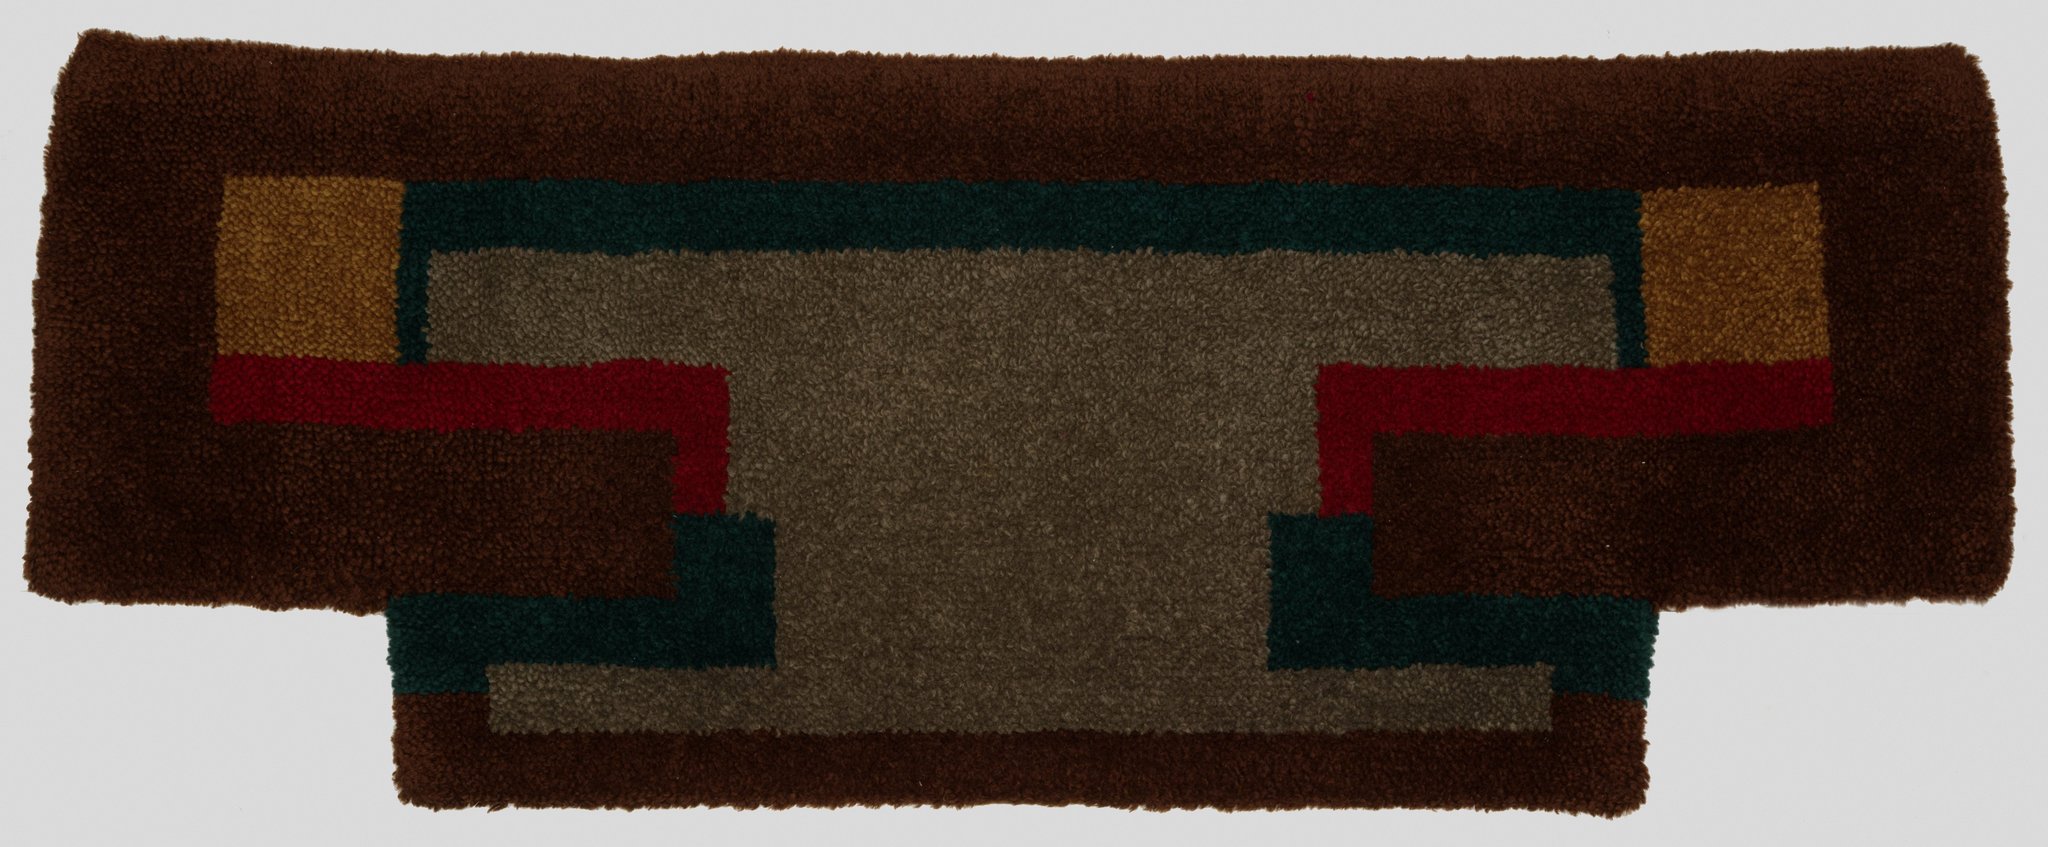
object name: kleed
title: Vloerkleed van wol met effen blokken en vierkanten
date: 1910-1927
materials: wool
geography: netherlands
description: Vloerkleed van wol met effen blokken en vierkanten, behorende bij kamerinrichting naar ontwerp G.C. Schubad.